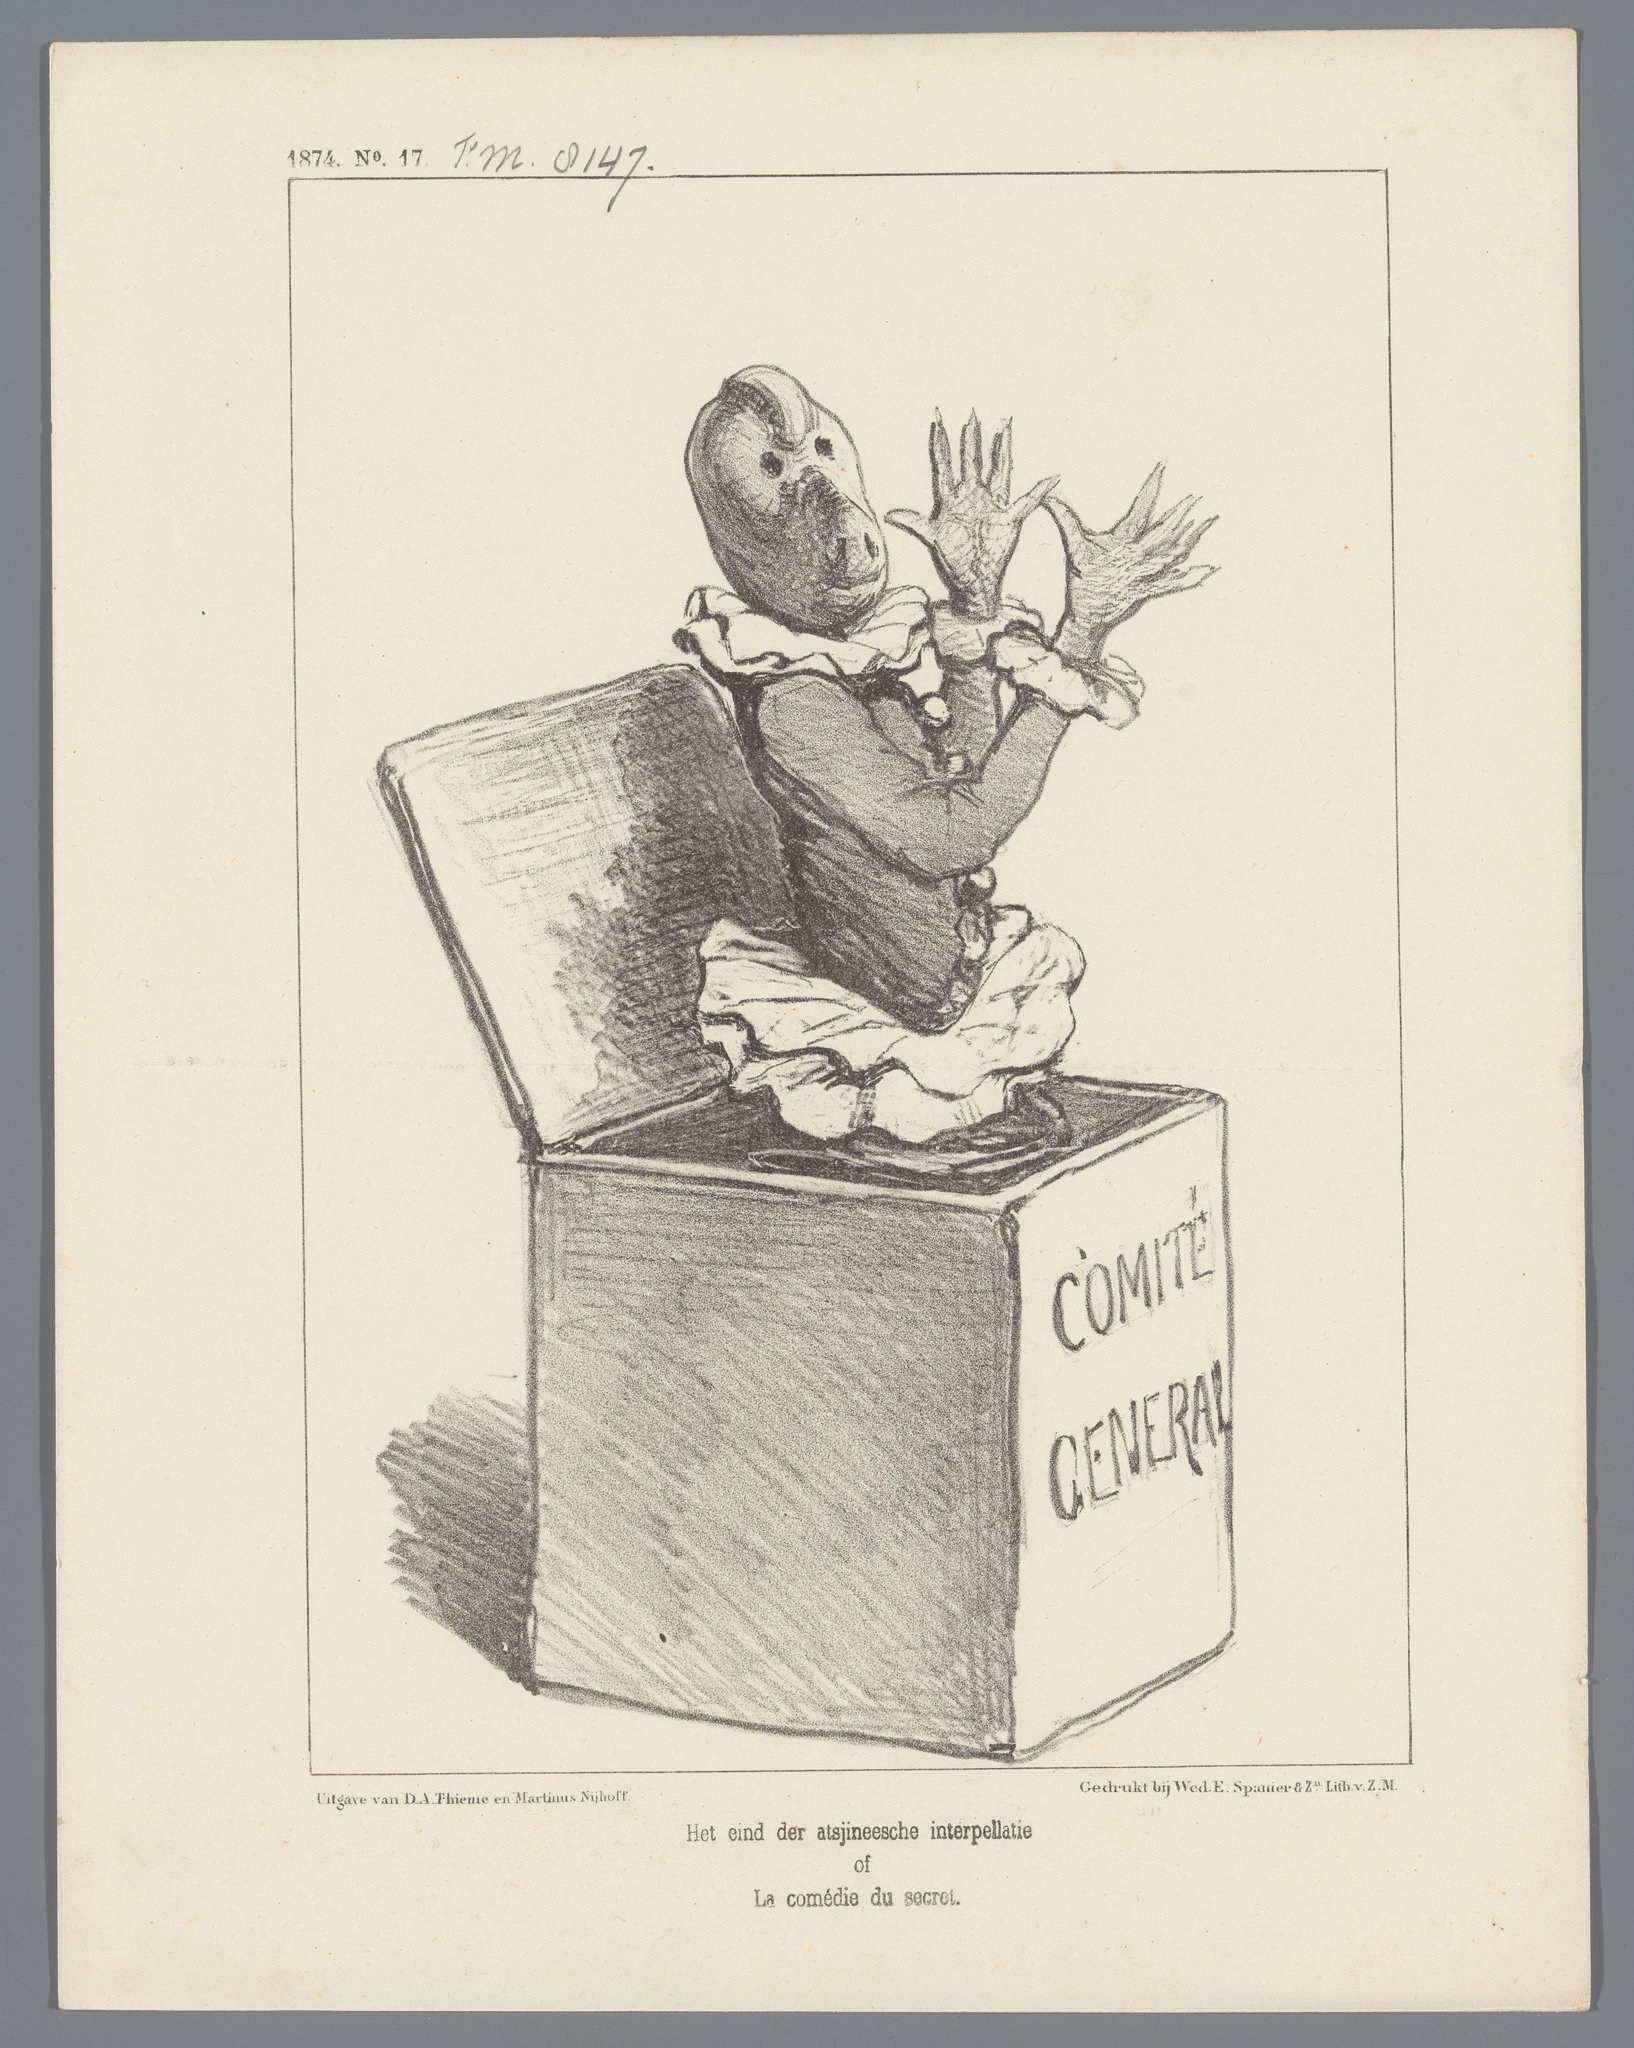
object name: print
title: Het eind der asjineesche interpellatie of La comédie du secret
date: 1874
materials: paper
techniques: lithograph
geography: netherlands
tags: tweede kamer der staten-generaal, atjeh, tweede atjehexpeditie (1873-1874)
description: Spotprent op het einde van het Atjeh debat, 1874. Plaat verschenen bij het weekblad De Nederlandsche Spectator, nr. 17, 1874.